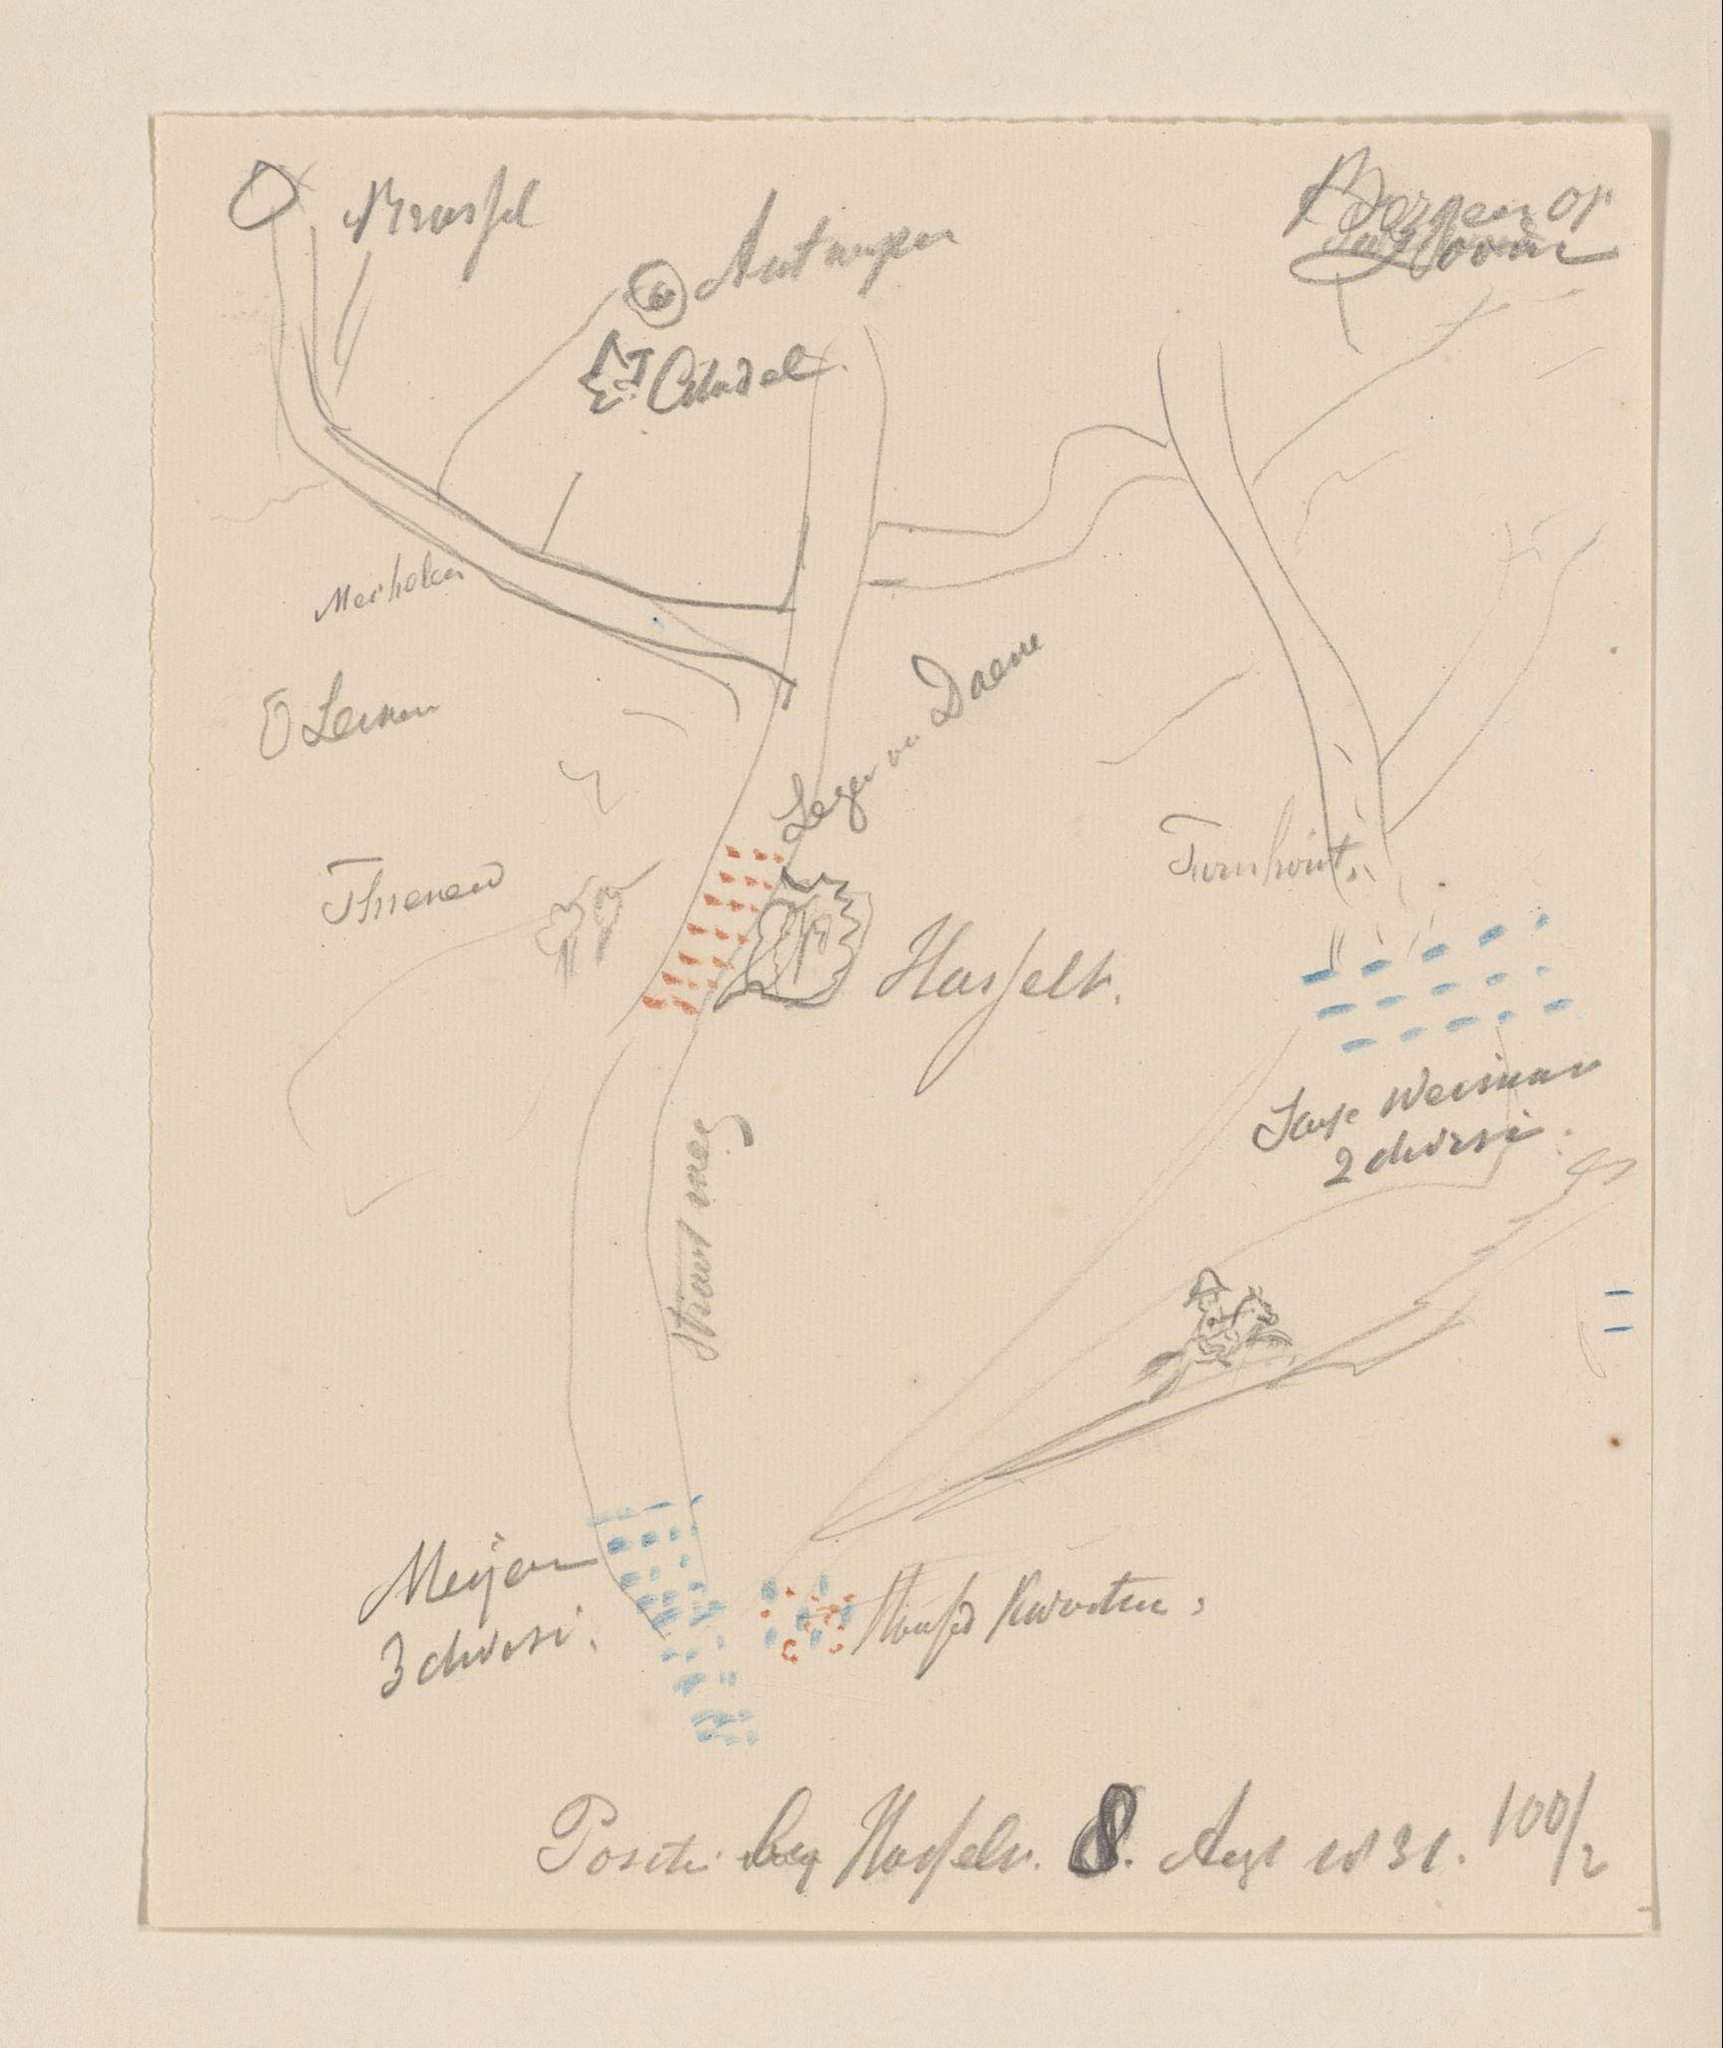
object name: drawing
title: Positie bij Hasselt 8 Aug. 1831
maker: Anonymous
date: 1831-1850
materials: paper, pencil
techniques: drawing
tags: battle arrays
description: Situatieschets van strategische posities van de Nederlandse en Belgische troepen bij de slag bij Hasselt, 8 augustus 1831.